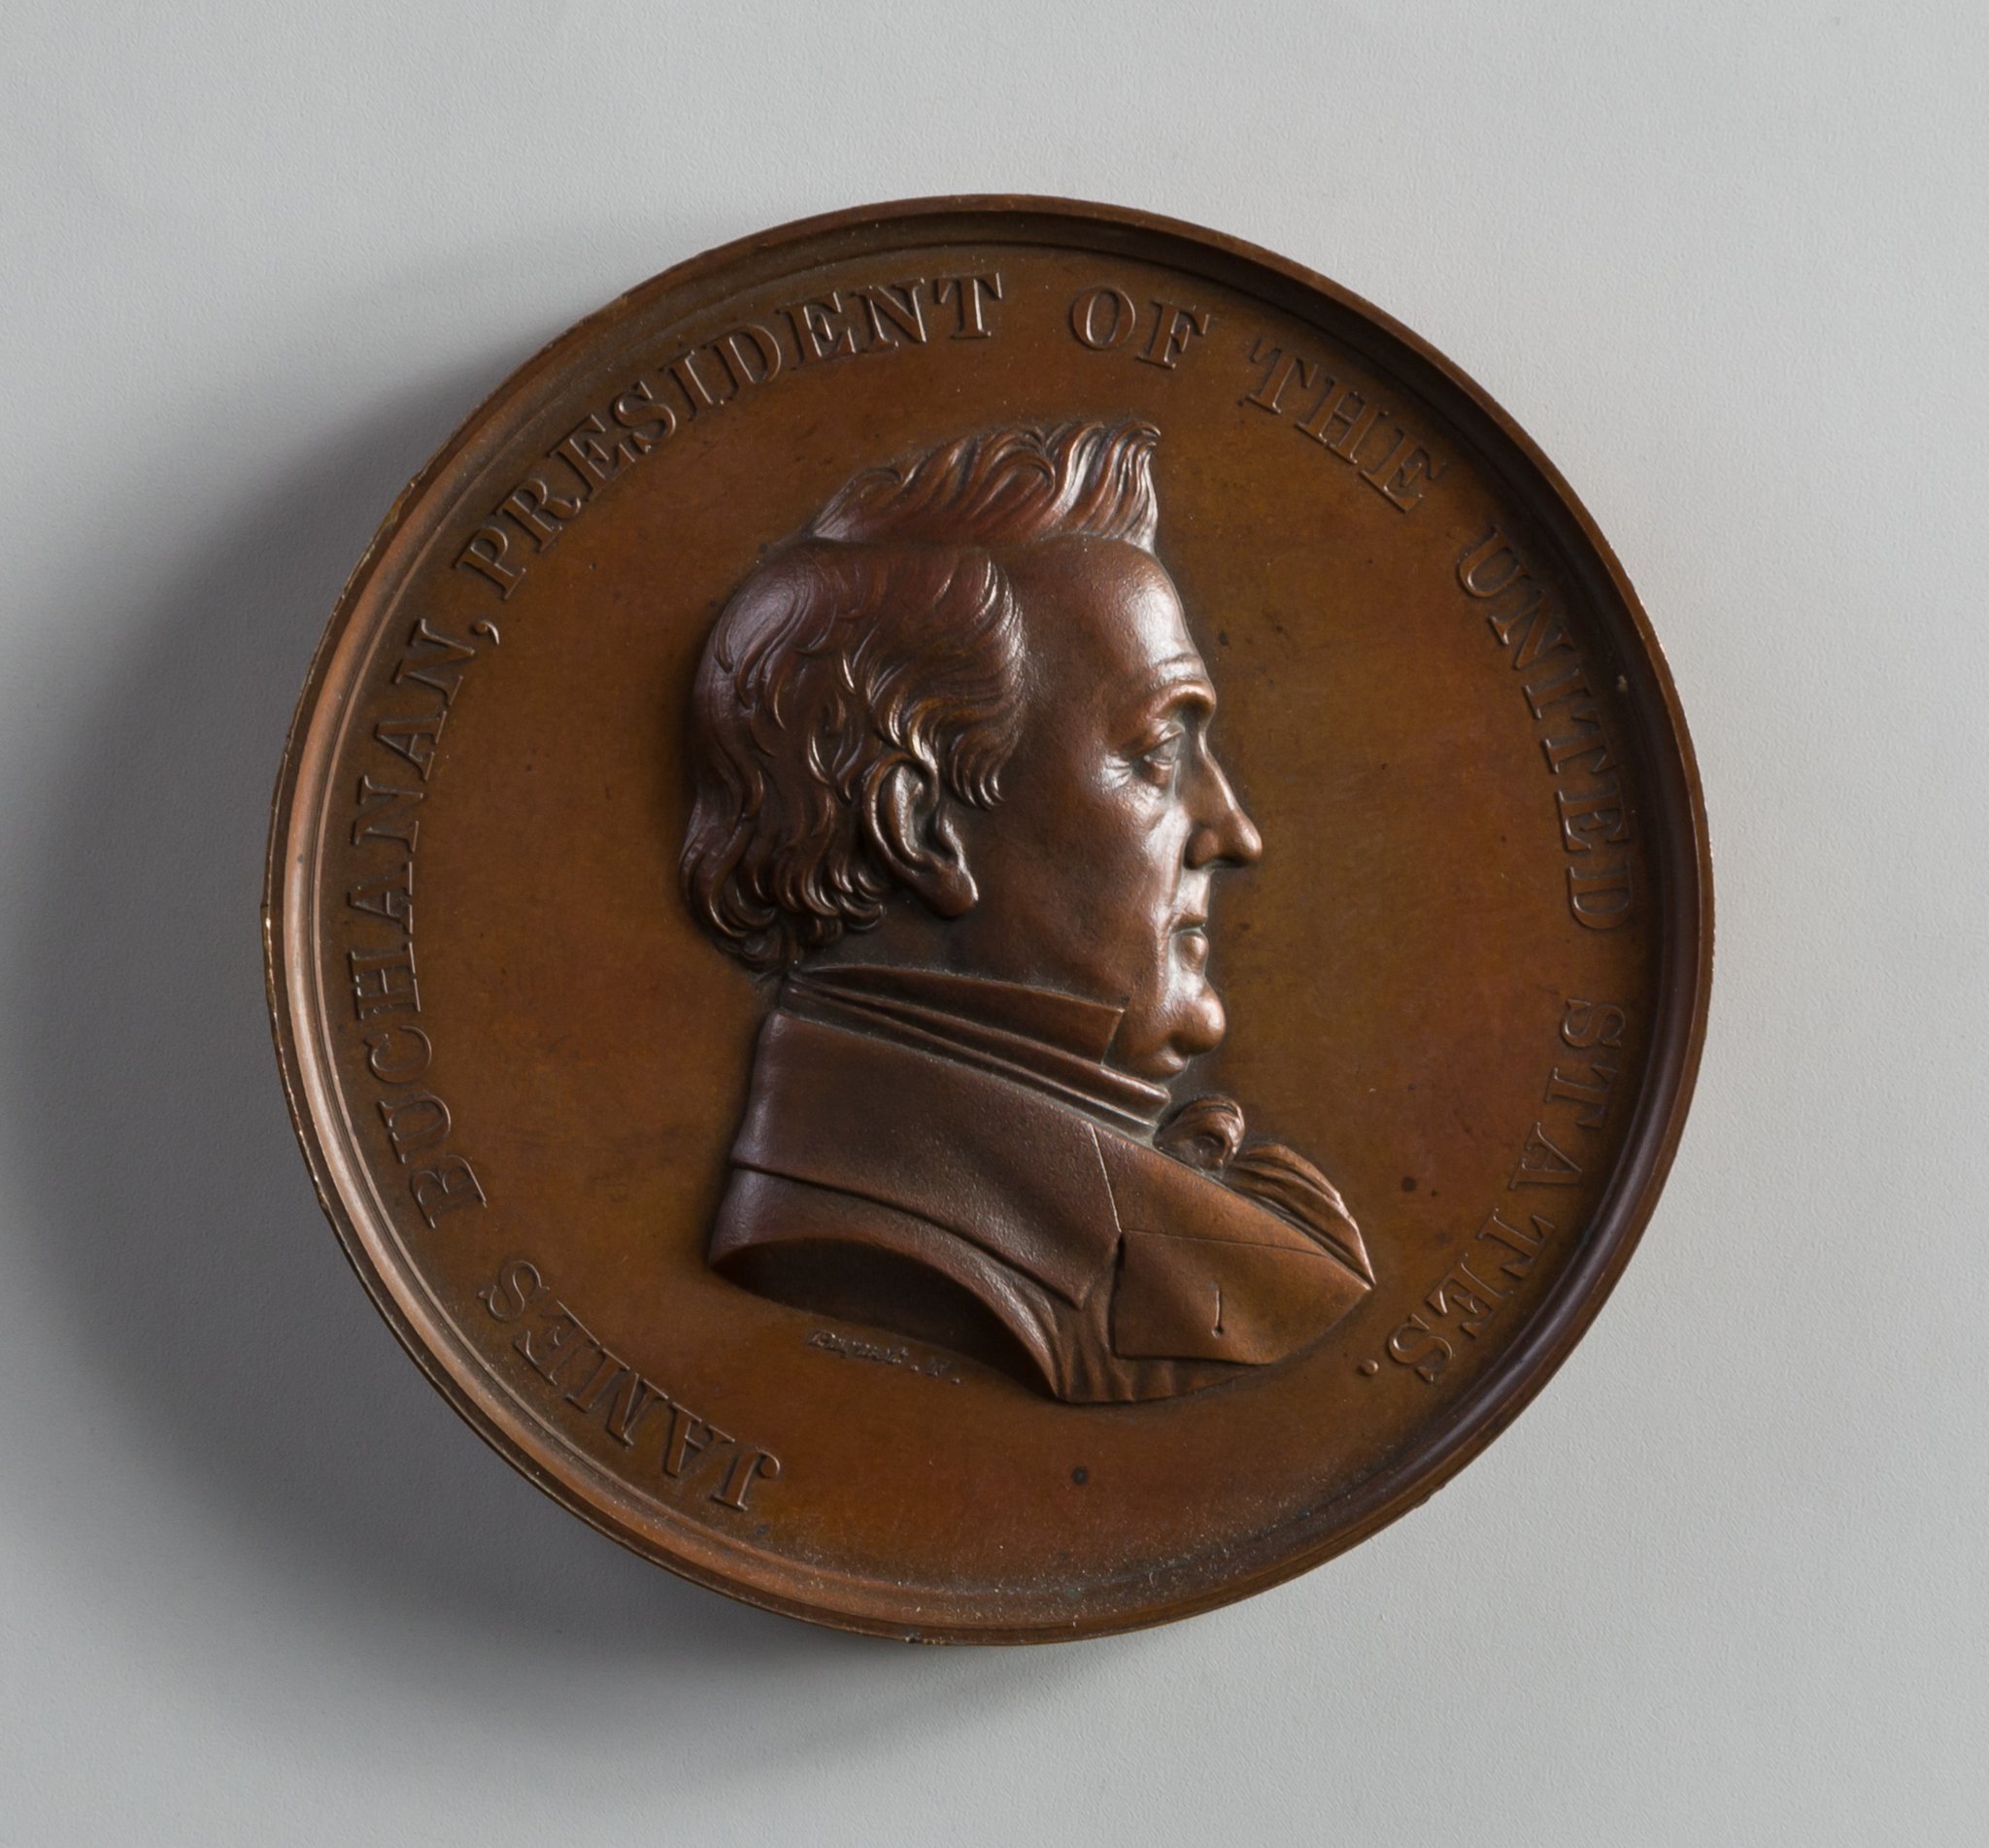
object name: medal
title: Medal to Dr. F. H. Rose, R. N.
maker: anthony paquet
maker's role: maker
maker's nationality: american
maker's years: 1814-1882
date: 1858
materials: bronze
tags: men,profiles